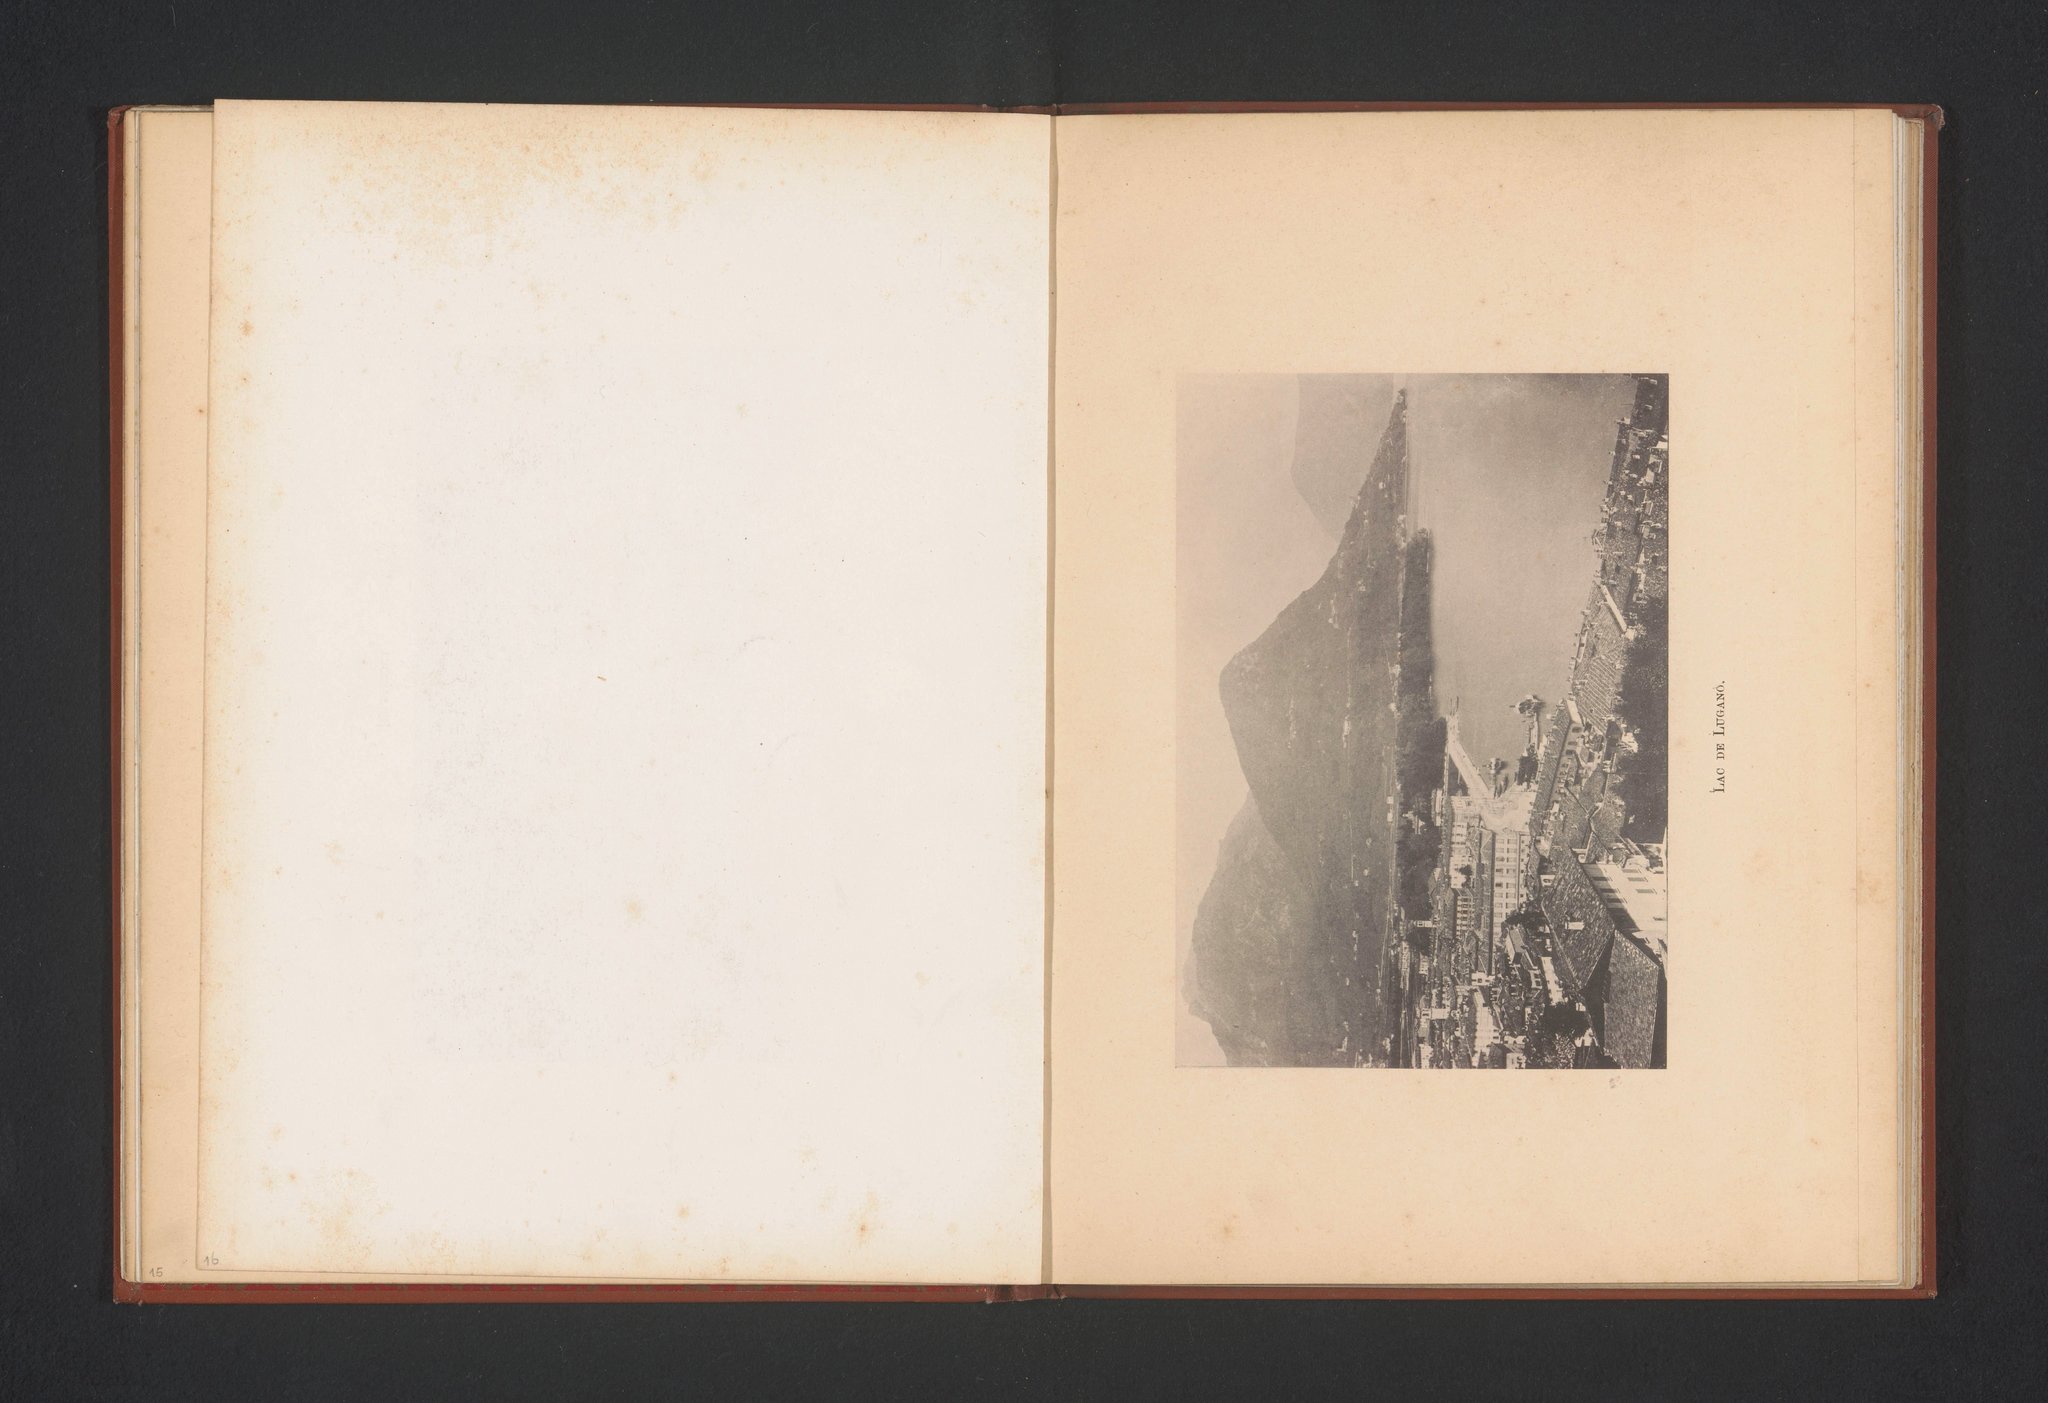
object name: page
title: Lac de Lugano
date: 1893-1898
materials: paper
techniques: photograph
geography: lake lugano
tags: city-view in general; 'veduta', lake, mountains